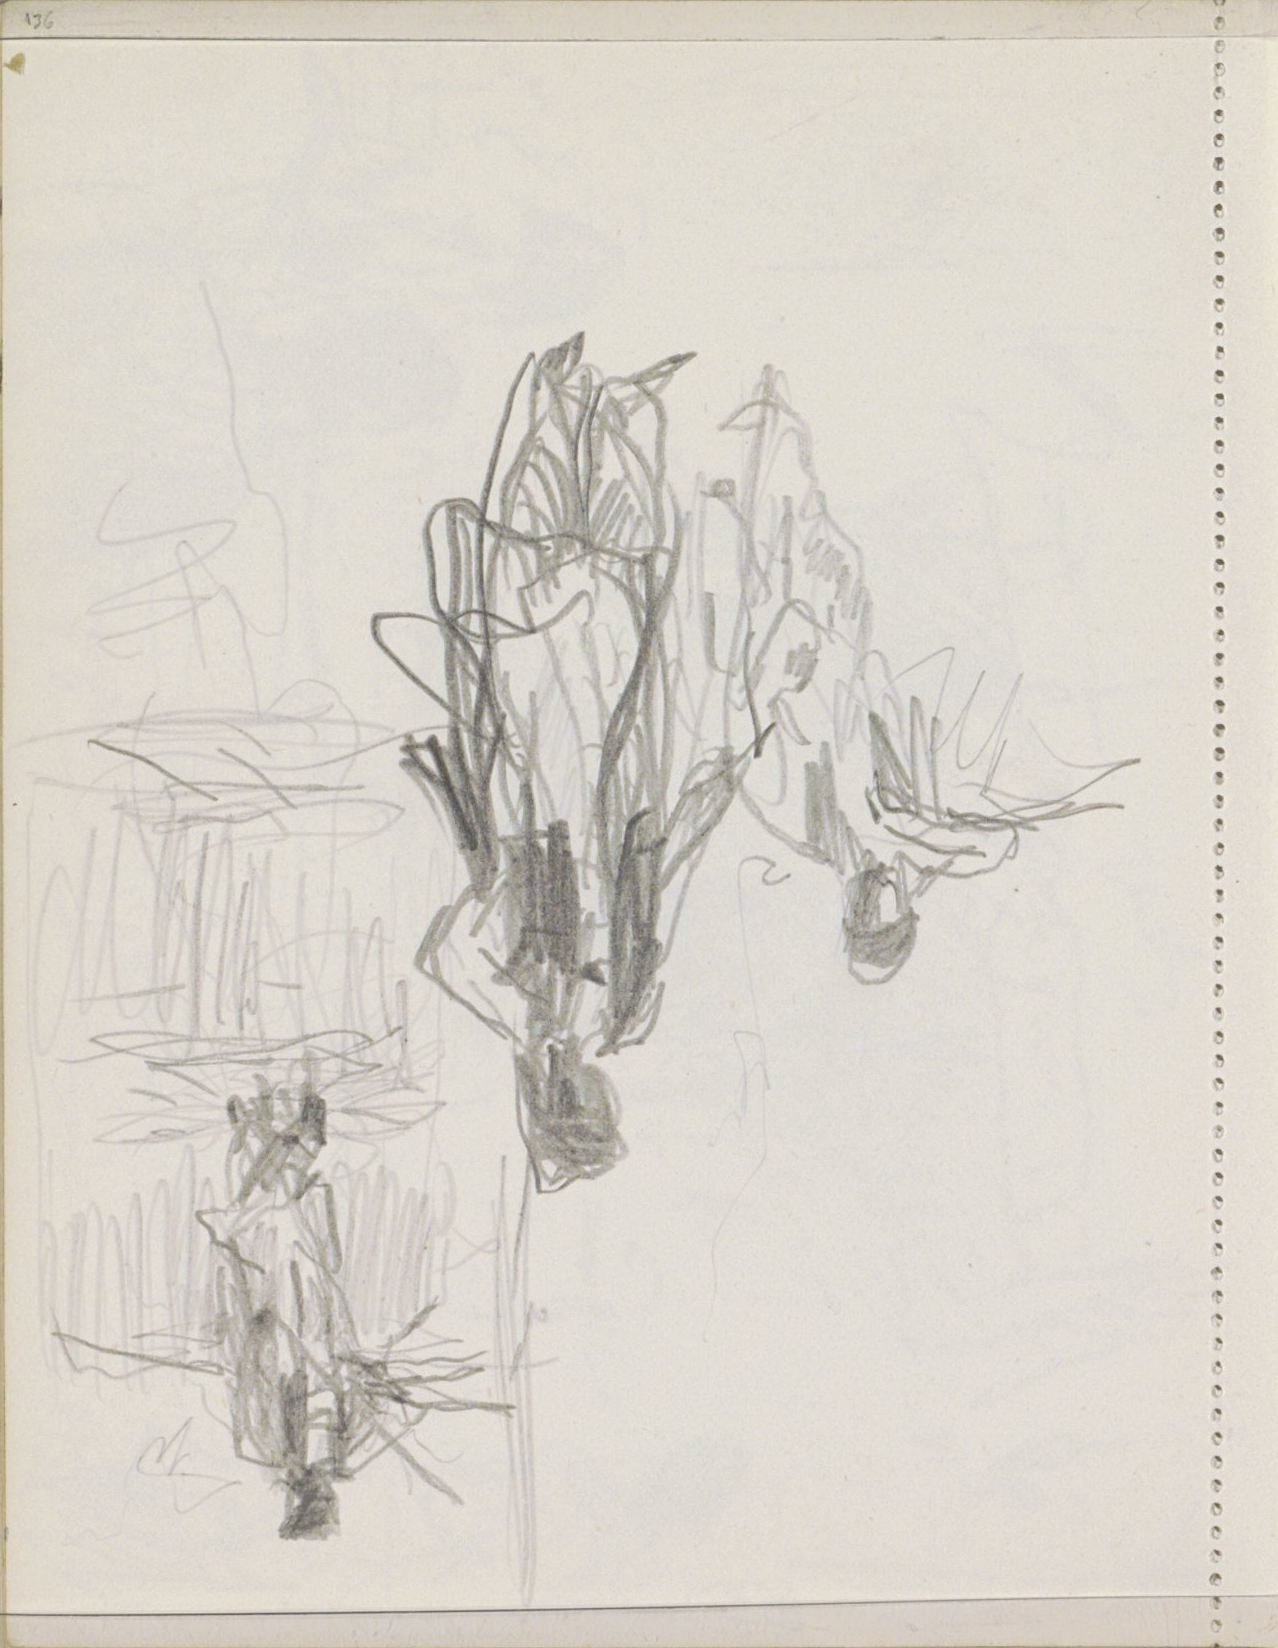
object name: sketchbook leaf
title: Twee Indiërs, waarvan één leunend tegen een muur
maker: marius bauer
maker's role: draughtsman, print maker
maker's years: 1867-1932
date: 1924-1925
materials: paper, pencil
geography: india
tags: leaning figure, asiatic races and peoples: indians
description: Tevens een studie van een Indiër, leunend bij een trap. Pagina 136 uit een schetsboek met 75 bladen.